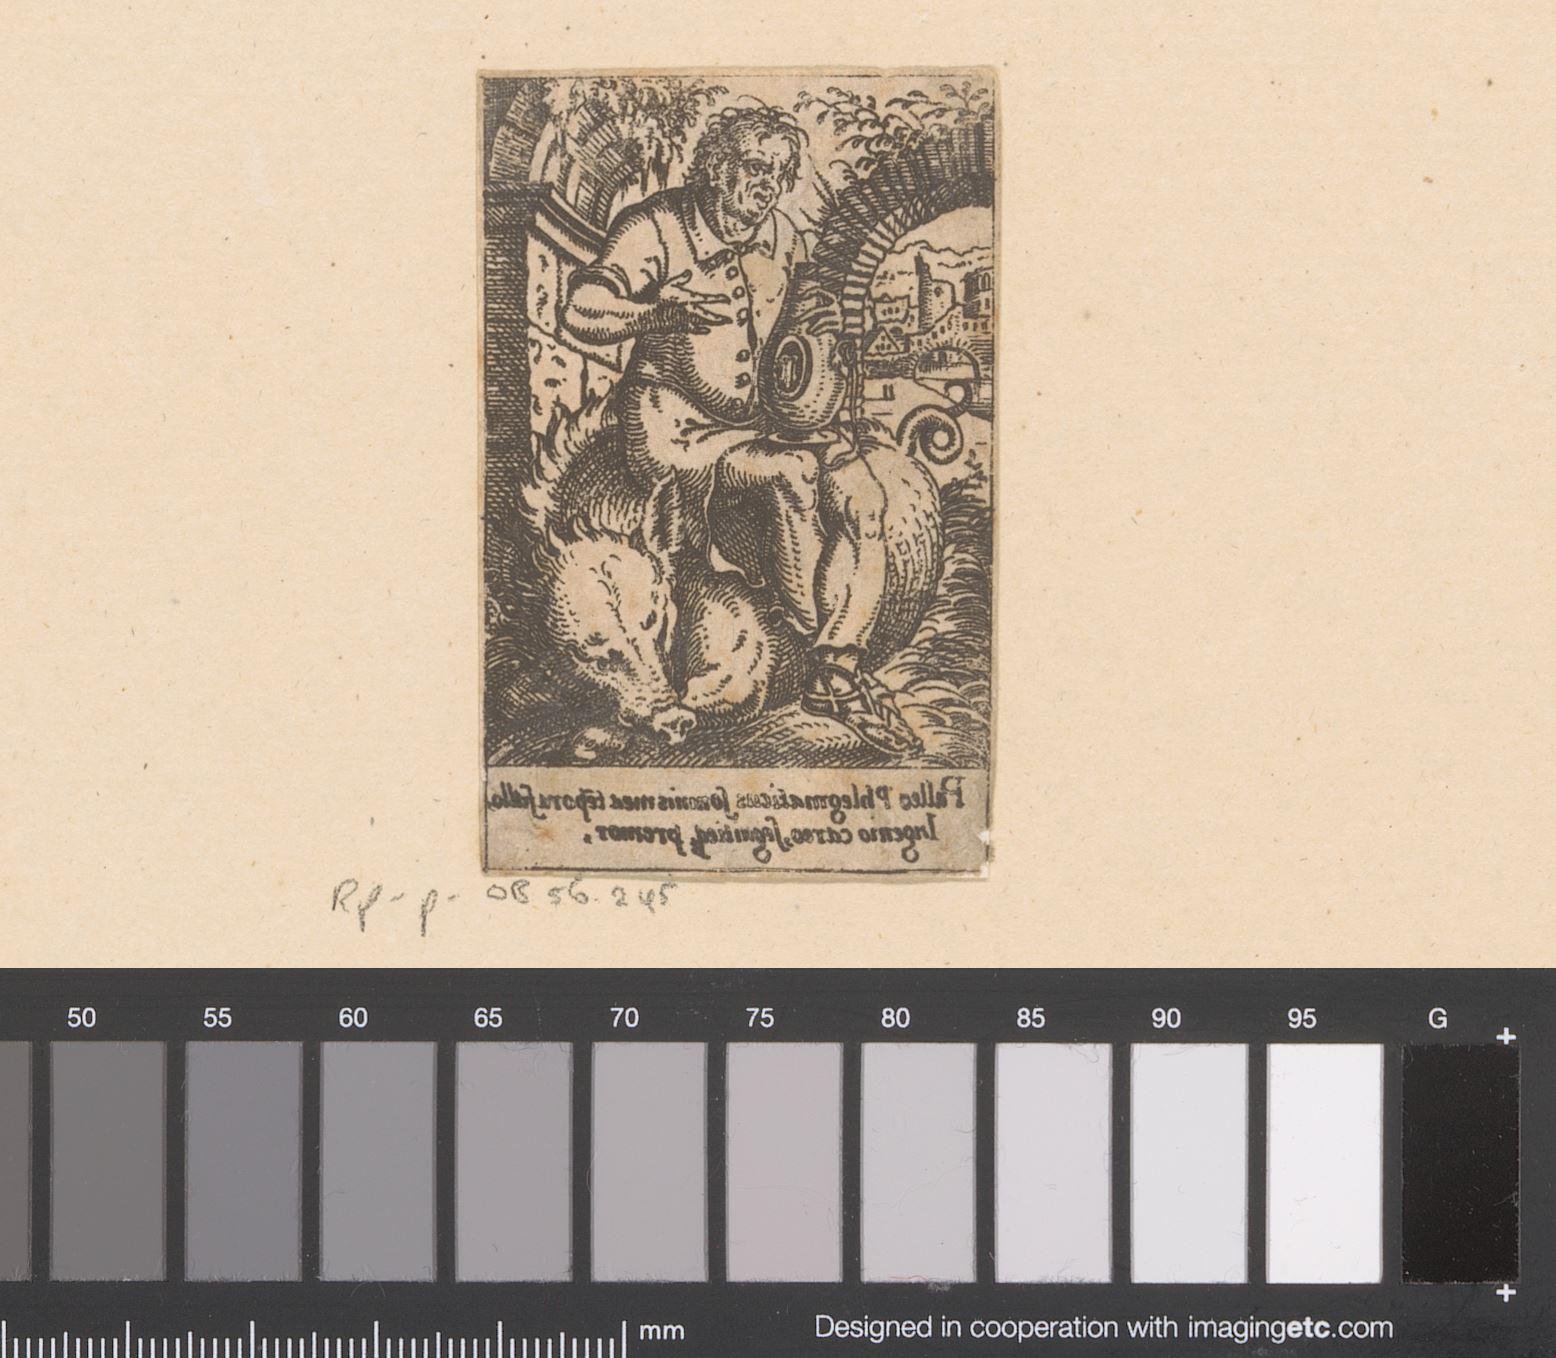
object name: print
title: Flegmatisch temperament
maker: Anonymous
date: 1549-1591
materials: paper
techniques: etching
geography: germany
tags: phlegmatic temperament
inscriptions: collector's mark: Lugt 2228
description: Gespiegelde versie van een serie van vier prenten van Jost Amman.